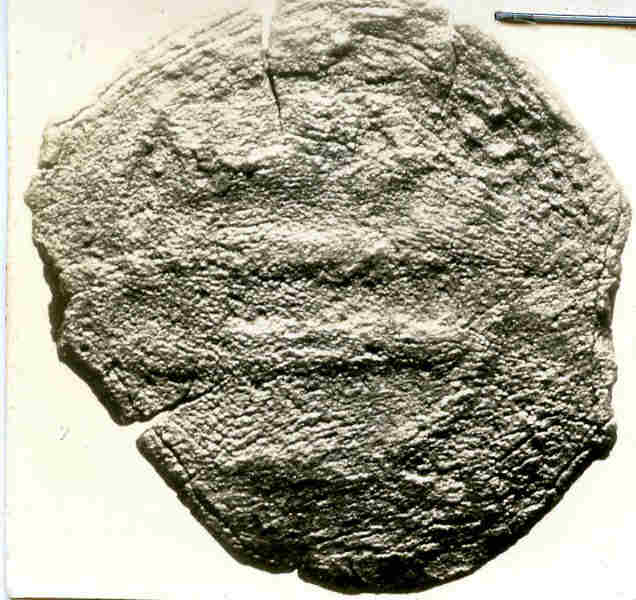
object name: coin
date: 701-900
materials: copper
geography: iran